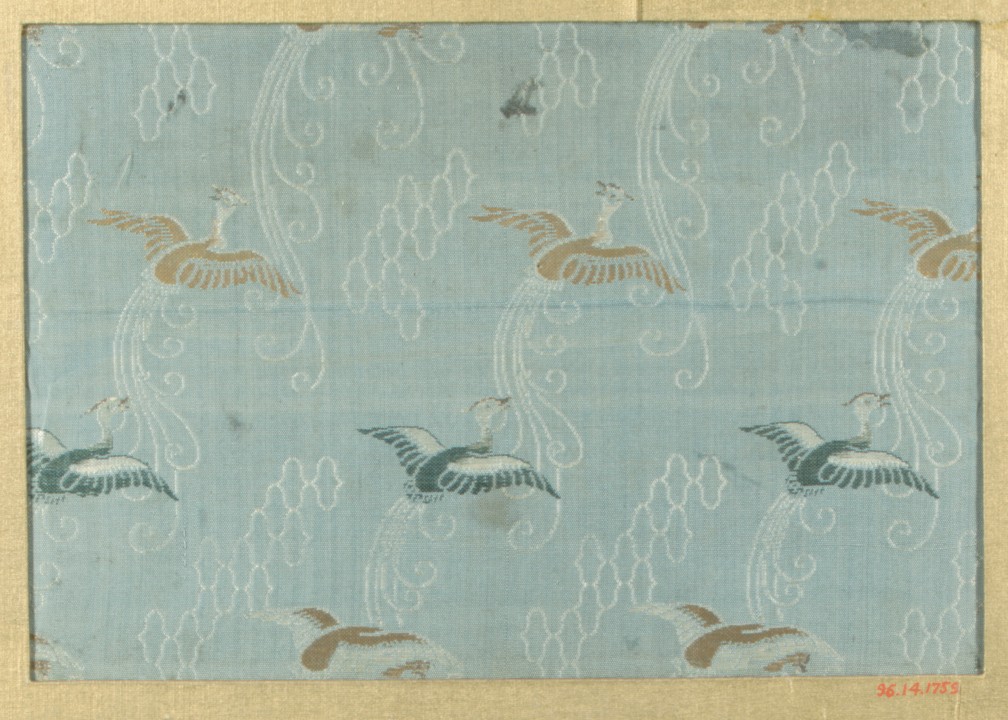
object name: piece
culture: japanese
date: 1701-1900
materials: silk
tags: birds